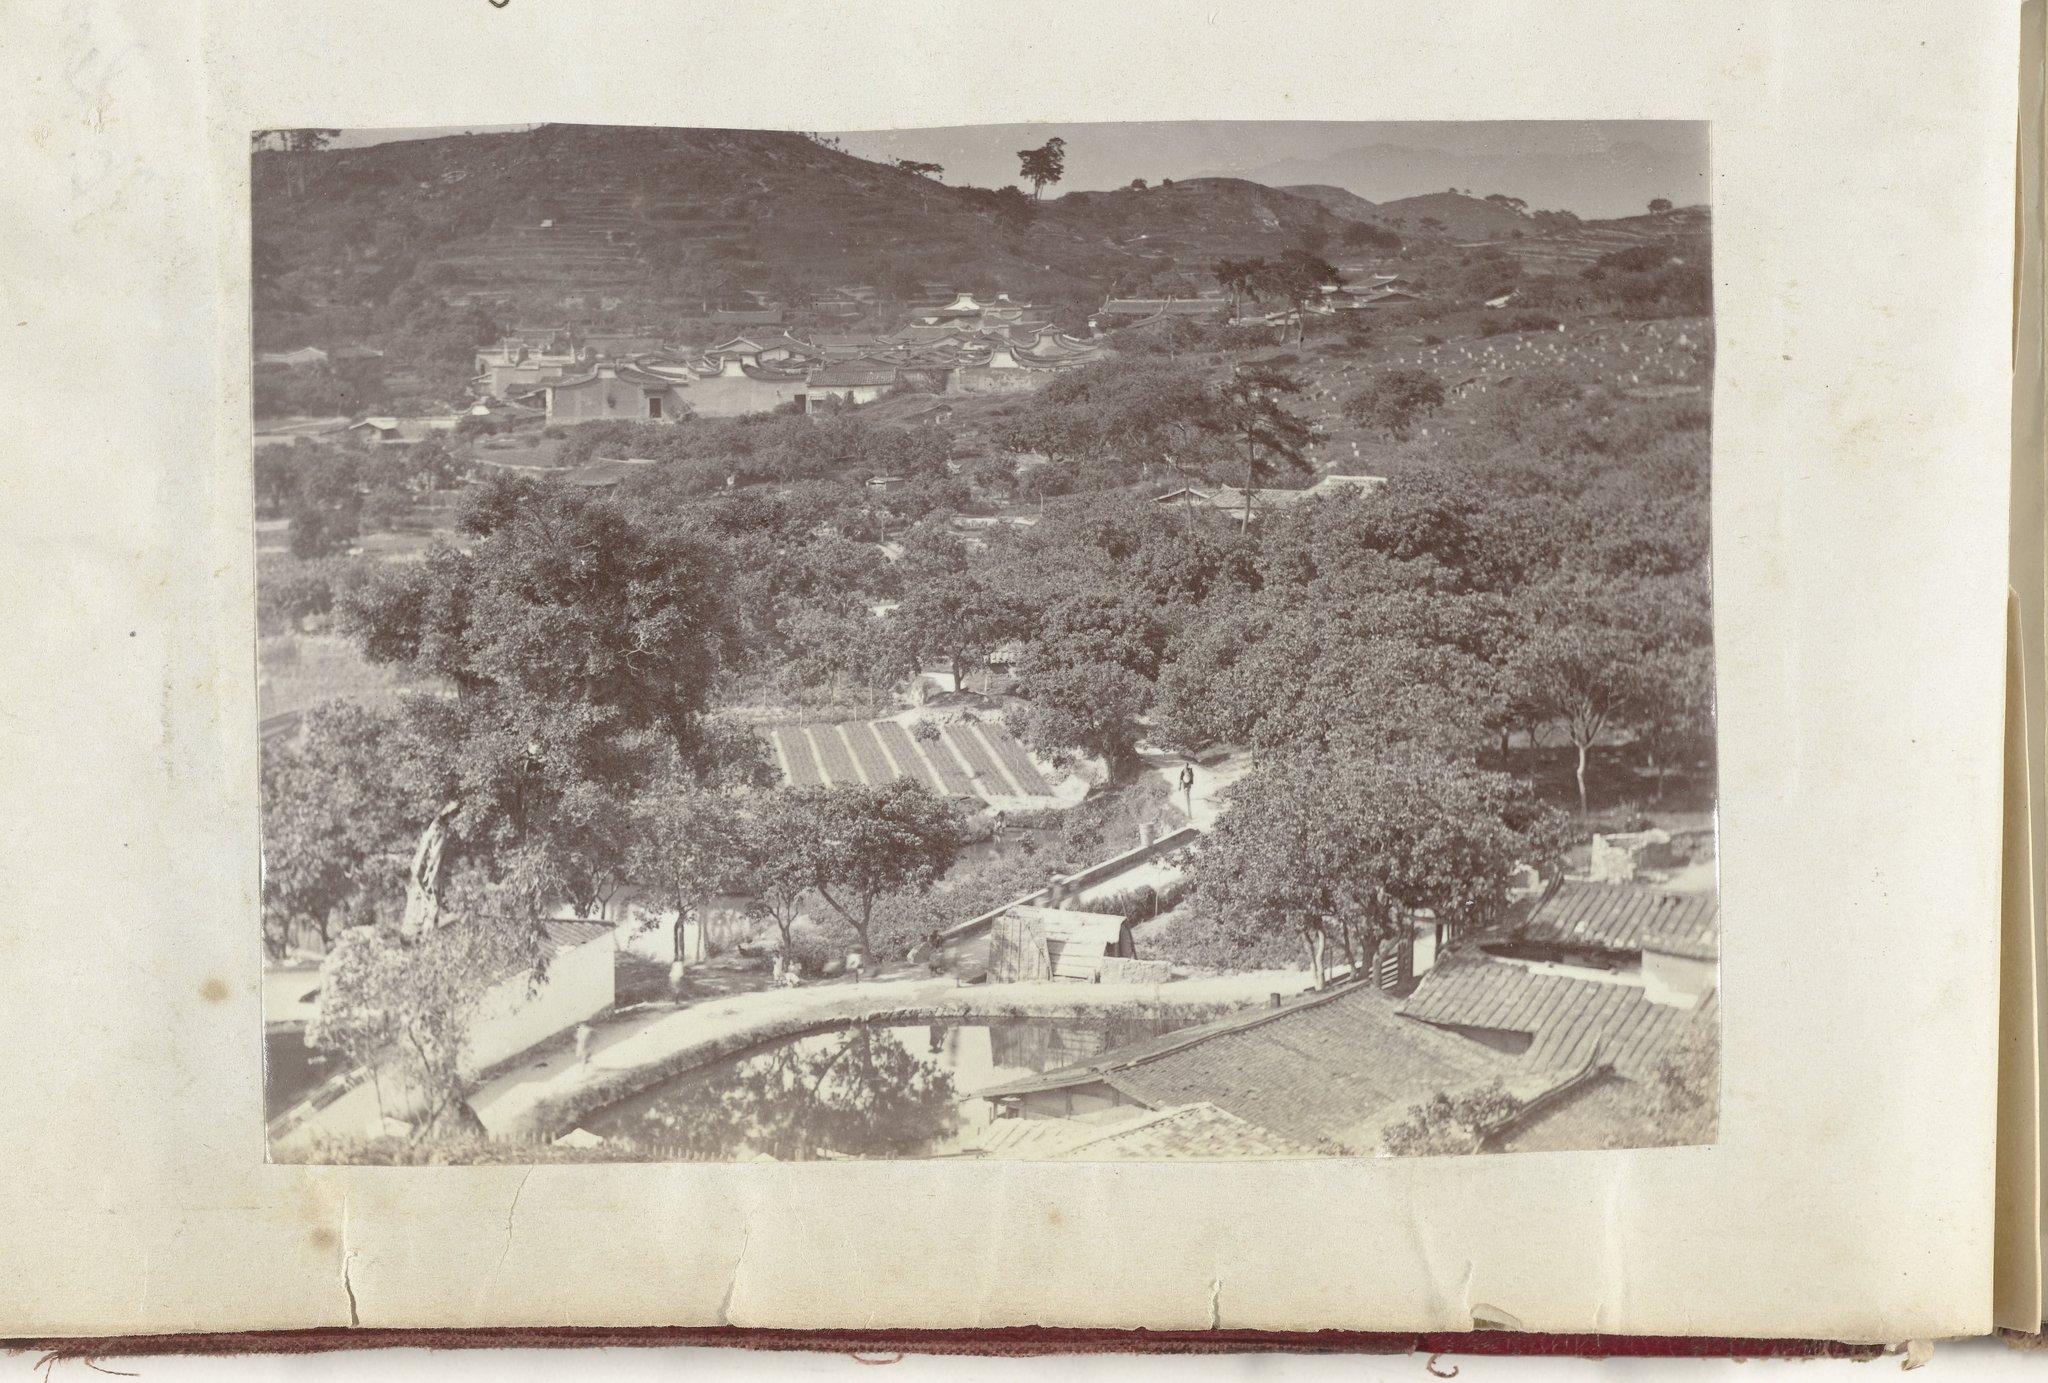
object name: album leaf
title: Gezicht op een heuvelachtig landschap in China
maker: Anonymous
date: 1879-1890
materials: paper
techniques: albumen print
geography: china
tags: prospect of village, silhouette of village, (high) hill, china